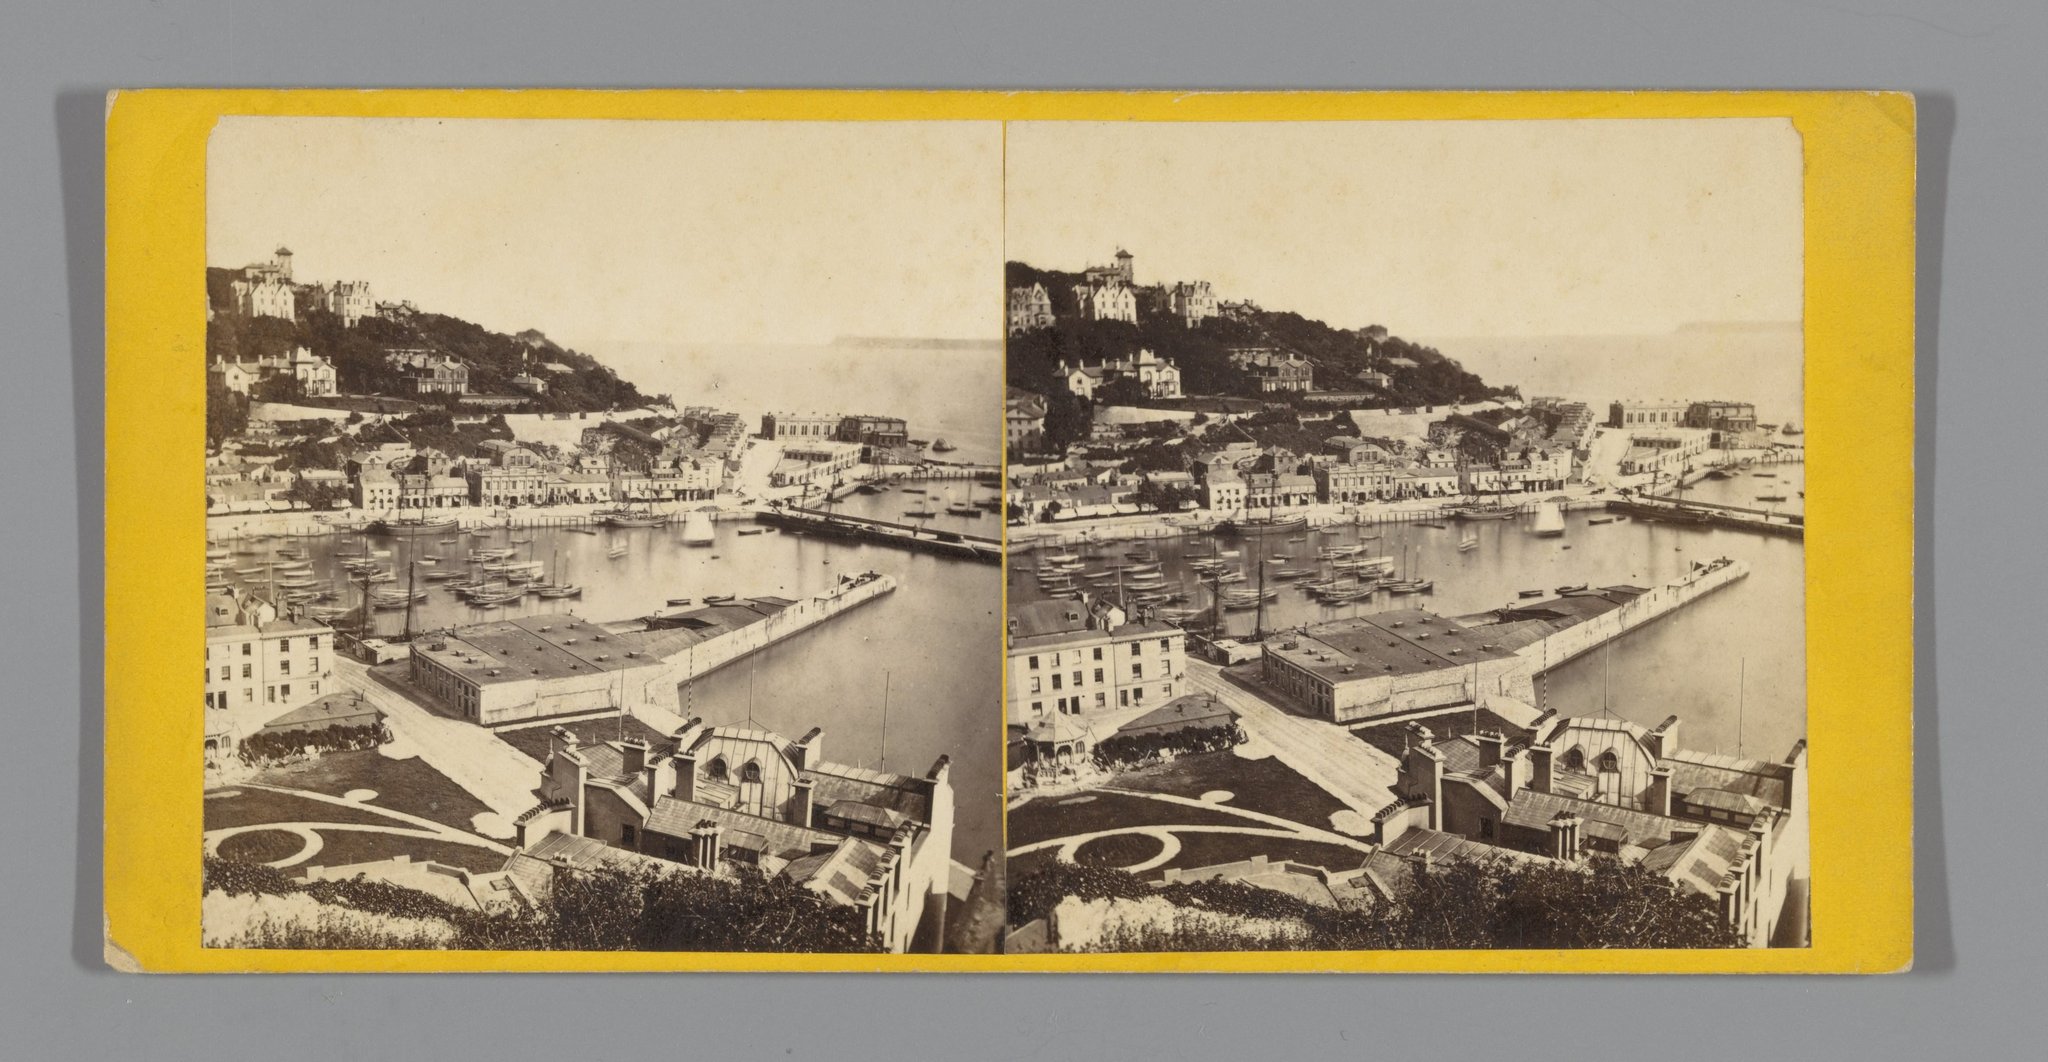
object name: stereograph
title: Torquay-from Waldon Hill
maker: w. widger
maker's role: fotograaf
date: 1850-1880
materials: cardboard, photographic support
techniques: albumen print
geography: devon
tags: city-view in general; 'veduta'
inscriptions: name: ‘Photographed by W. Widger. Torquay.’